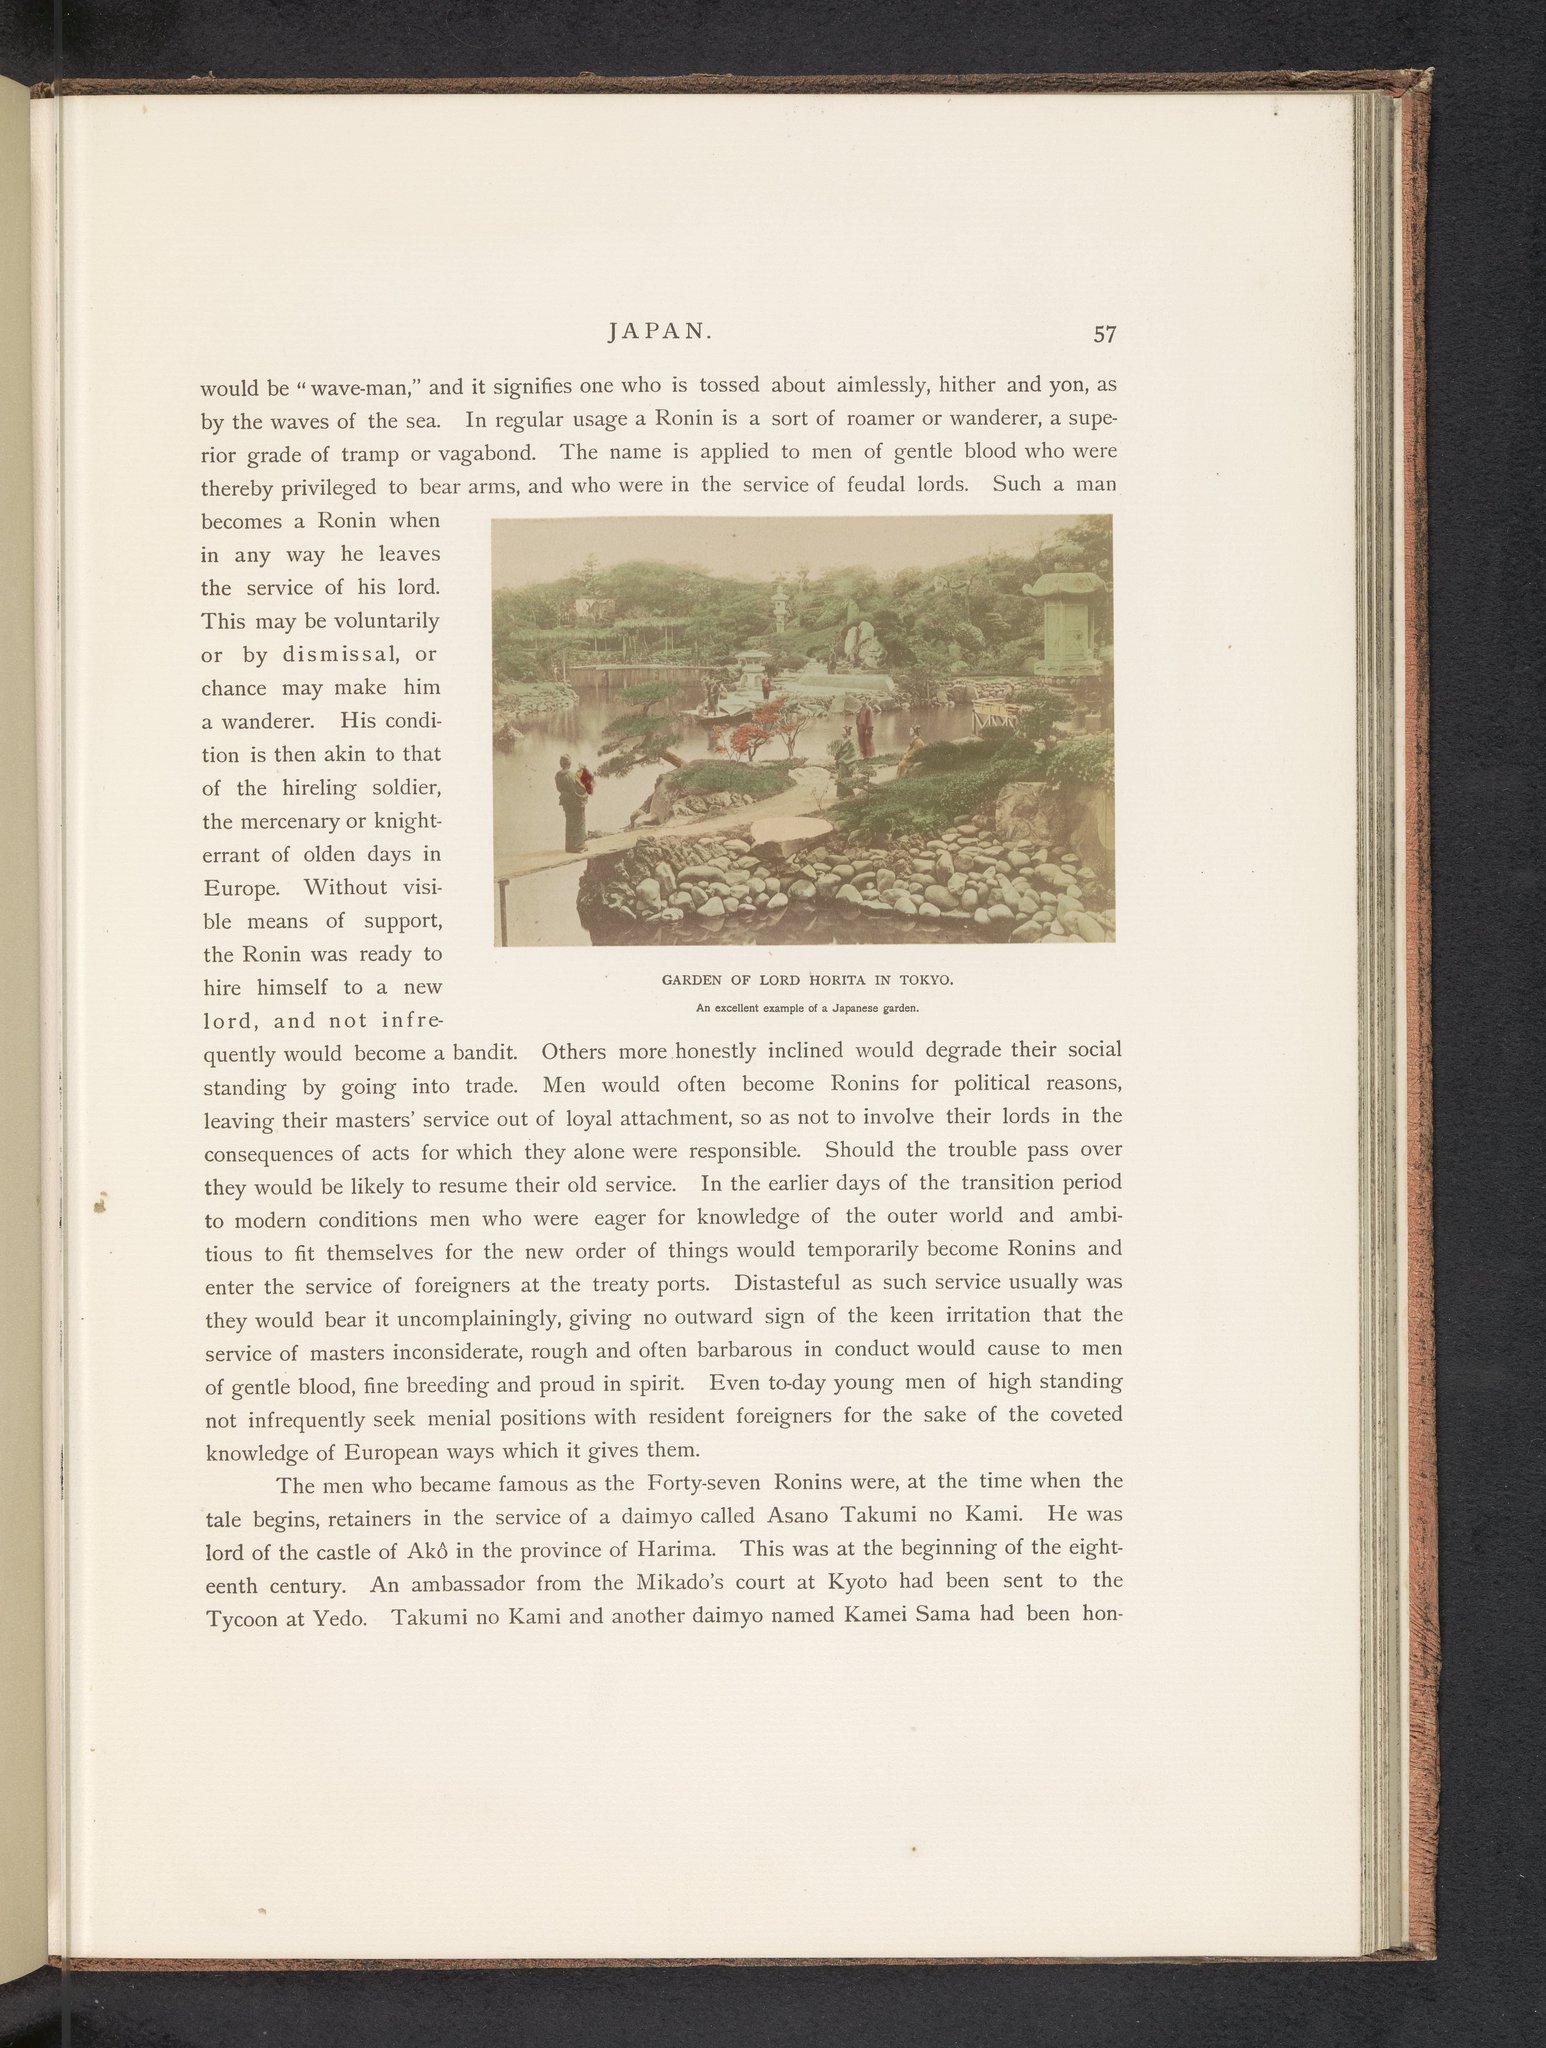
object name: page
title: Garden of Lord Horita in Tokyo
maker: Anonymous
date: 1887-1897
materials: photographic support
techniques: albumen print, hand coloring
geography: japan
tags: rock-garden, pond, pool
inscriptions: inscription: ‘An excellent example of a Japanese garden.’